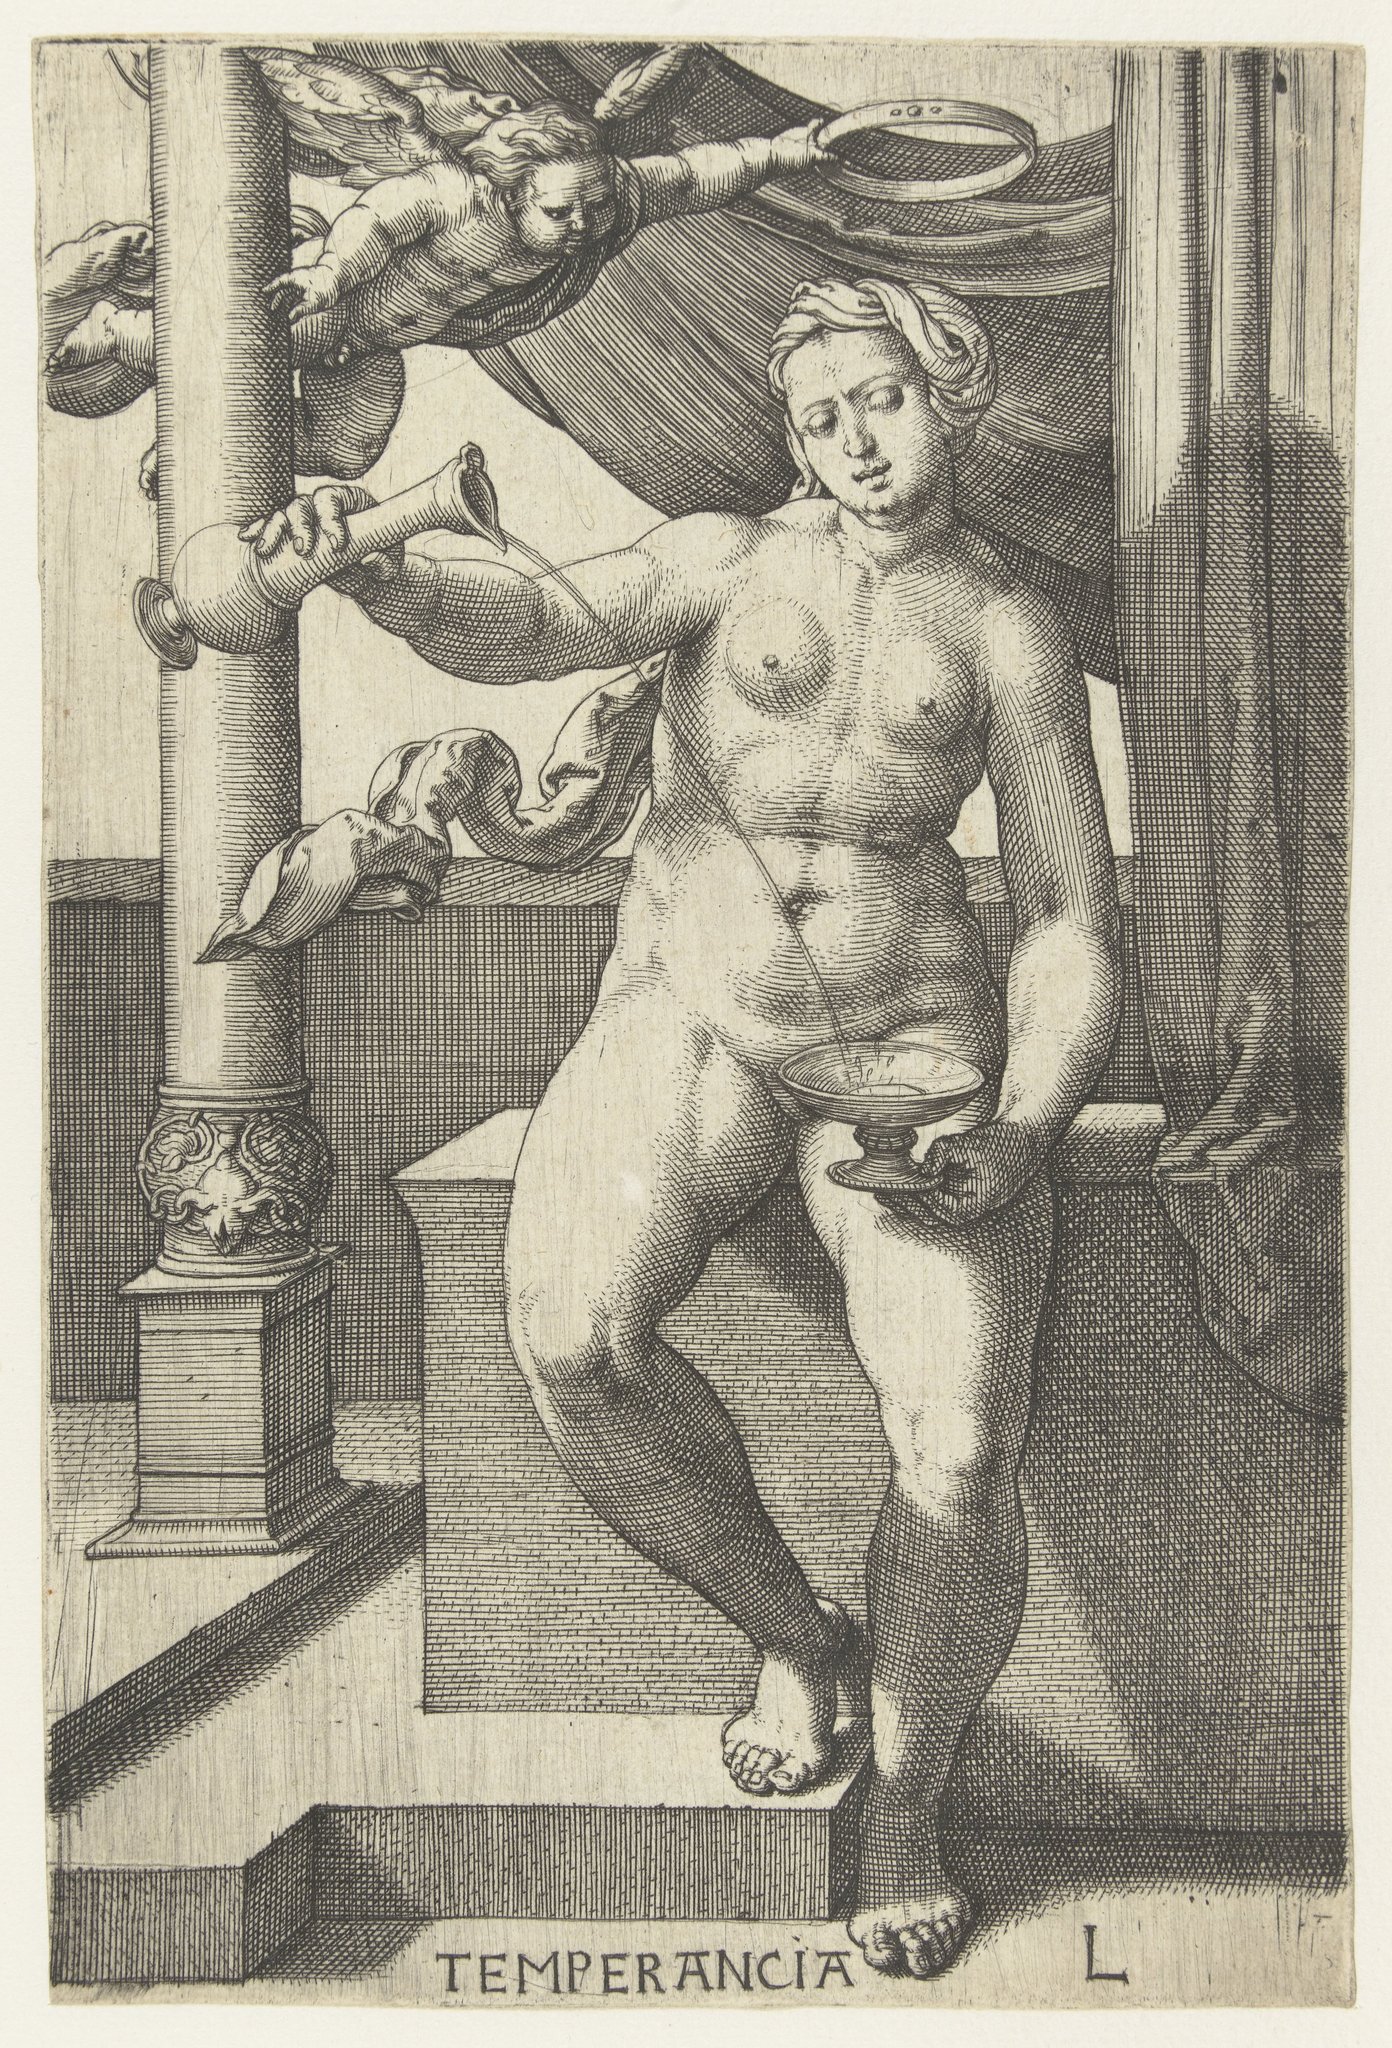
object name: print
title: Temperancia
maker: lucas van leyden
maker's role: draughtsman, painter, print maker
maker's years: 1494-1533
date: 1530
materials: paper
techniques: engraving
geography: low countries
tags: temperance, 'temperantia'; 'temperanza' (ripa) ~ one of the four cardinal virtues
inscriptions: collector's mark: Lugt 2228a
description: Personificatie van de deugd Gematigdheid: naakte vrouw schenkt water uit kan in kom, putto houdt cirkelvormige band boven haar hoofd.